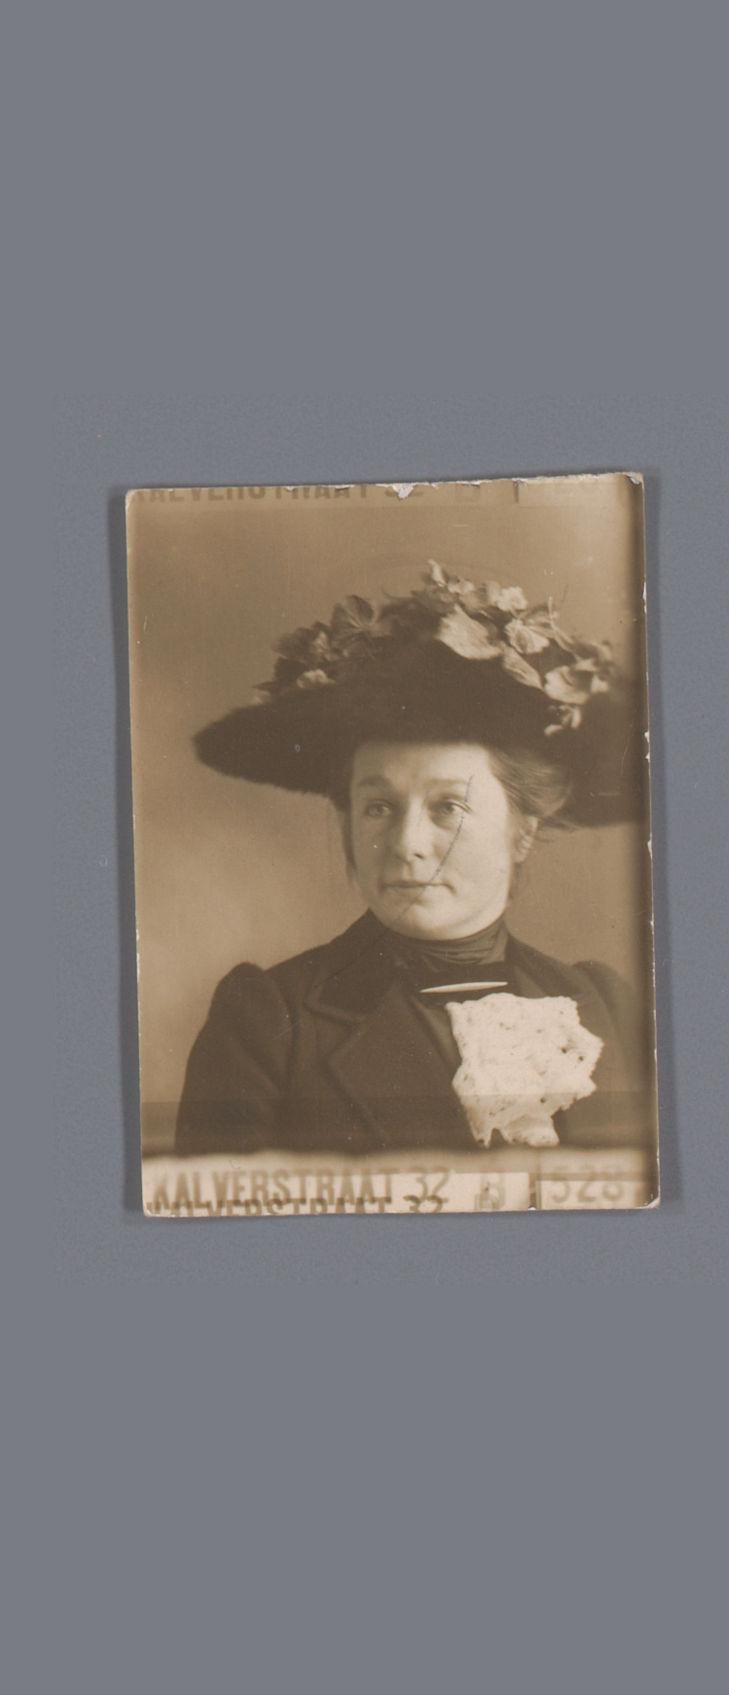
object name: photograph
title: Portret van Jennigje Hendrika Jacoba Jonker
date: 1912-1918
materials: photographic support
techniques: collodion silver print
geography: amsterdam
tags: historical persons